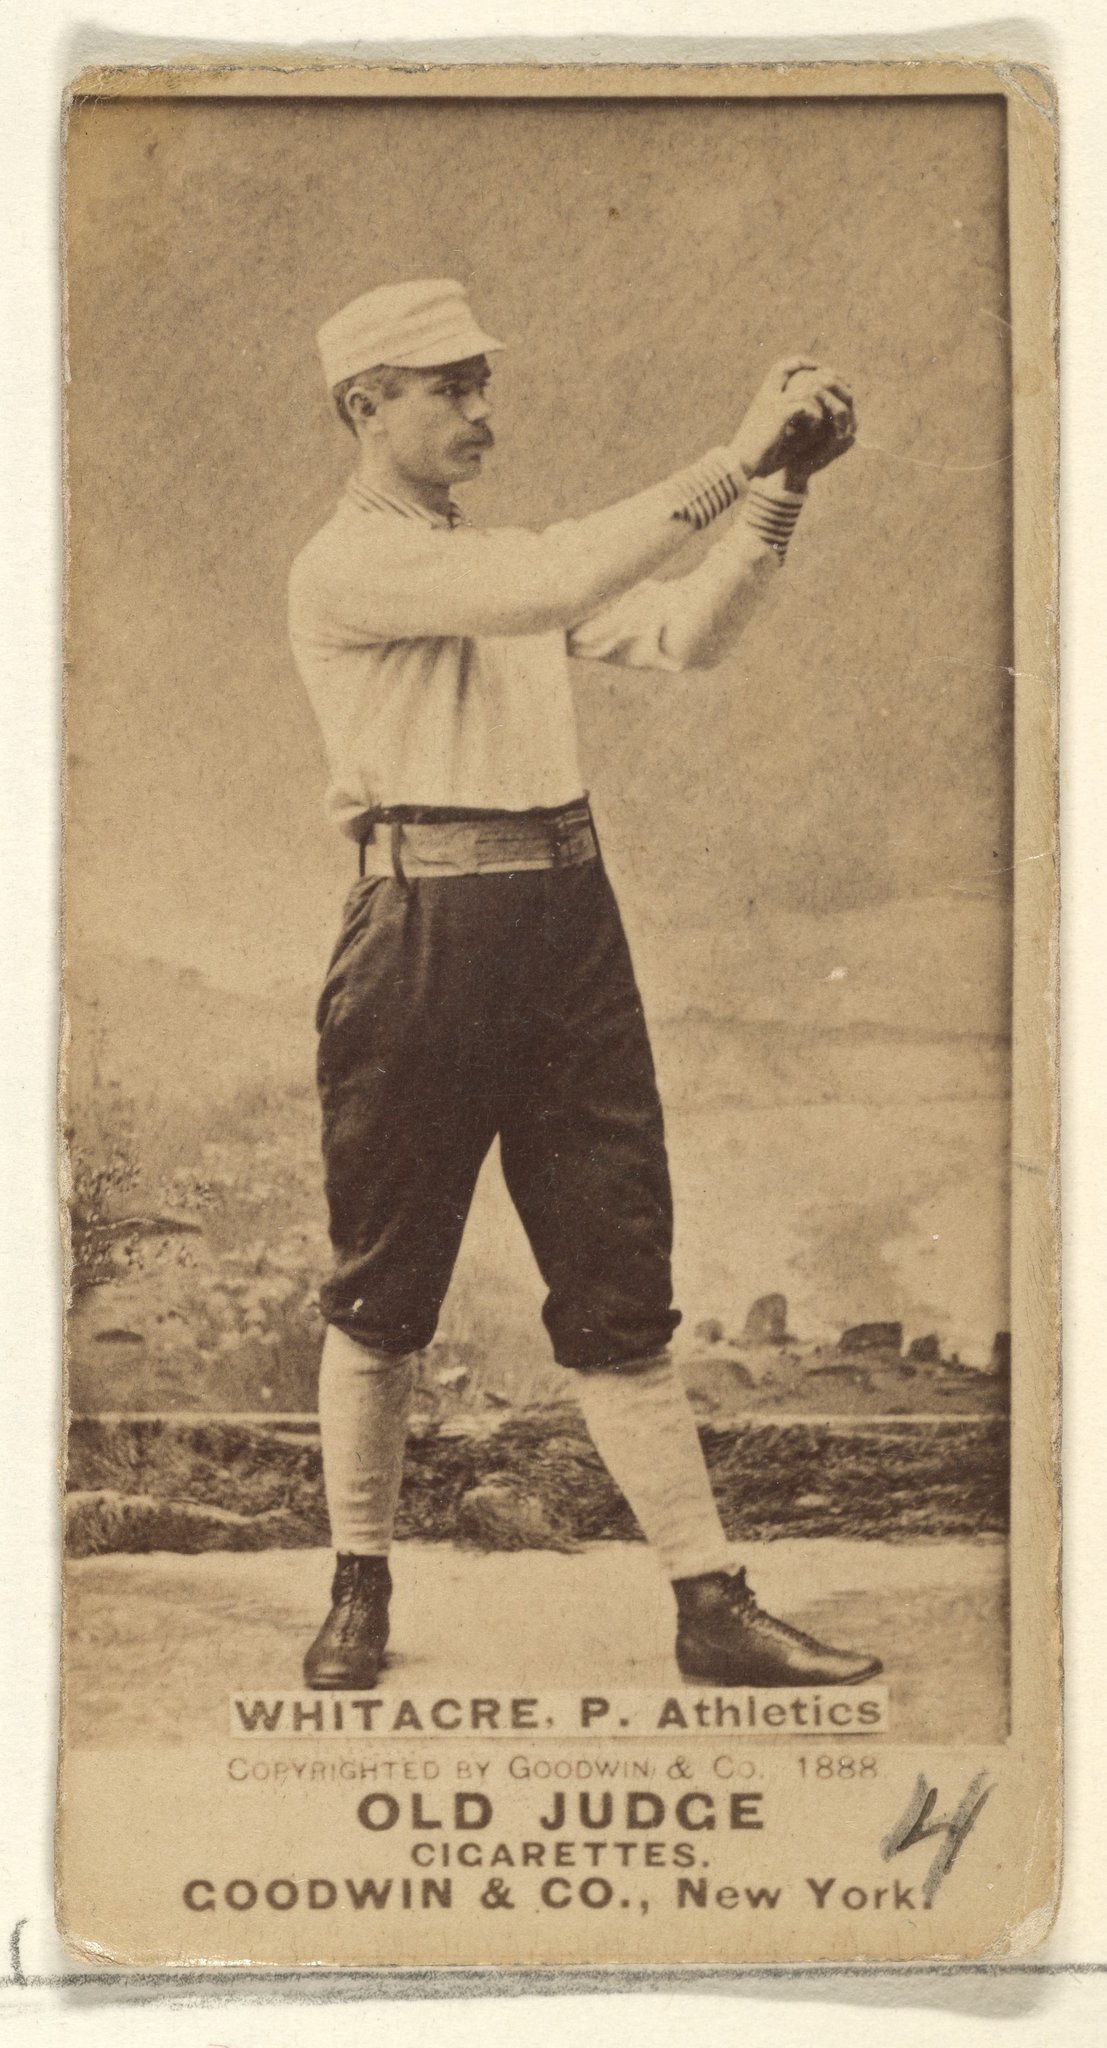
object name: baseball card, photograph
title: Whitacre, Pitcher, Philadelphia Athletics, from the Old Judge series (N172) for Old Judge Cigarettes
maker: goodwin & company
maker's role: publisher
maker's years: 1850-1950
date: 1888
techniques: albumen silver print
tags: men,portraits,baseball,athletes